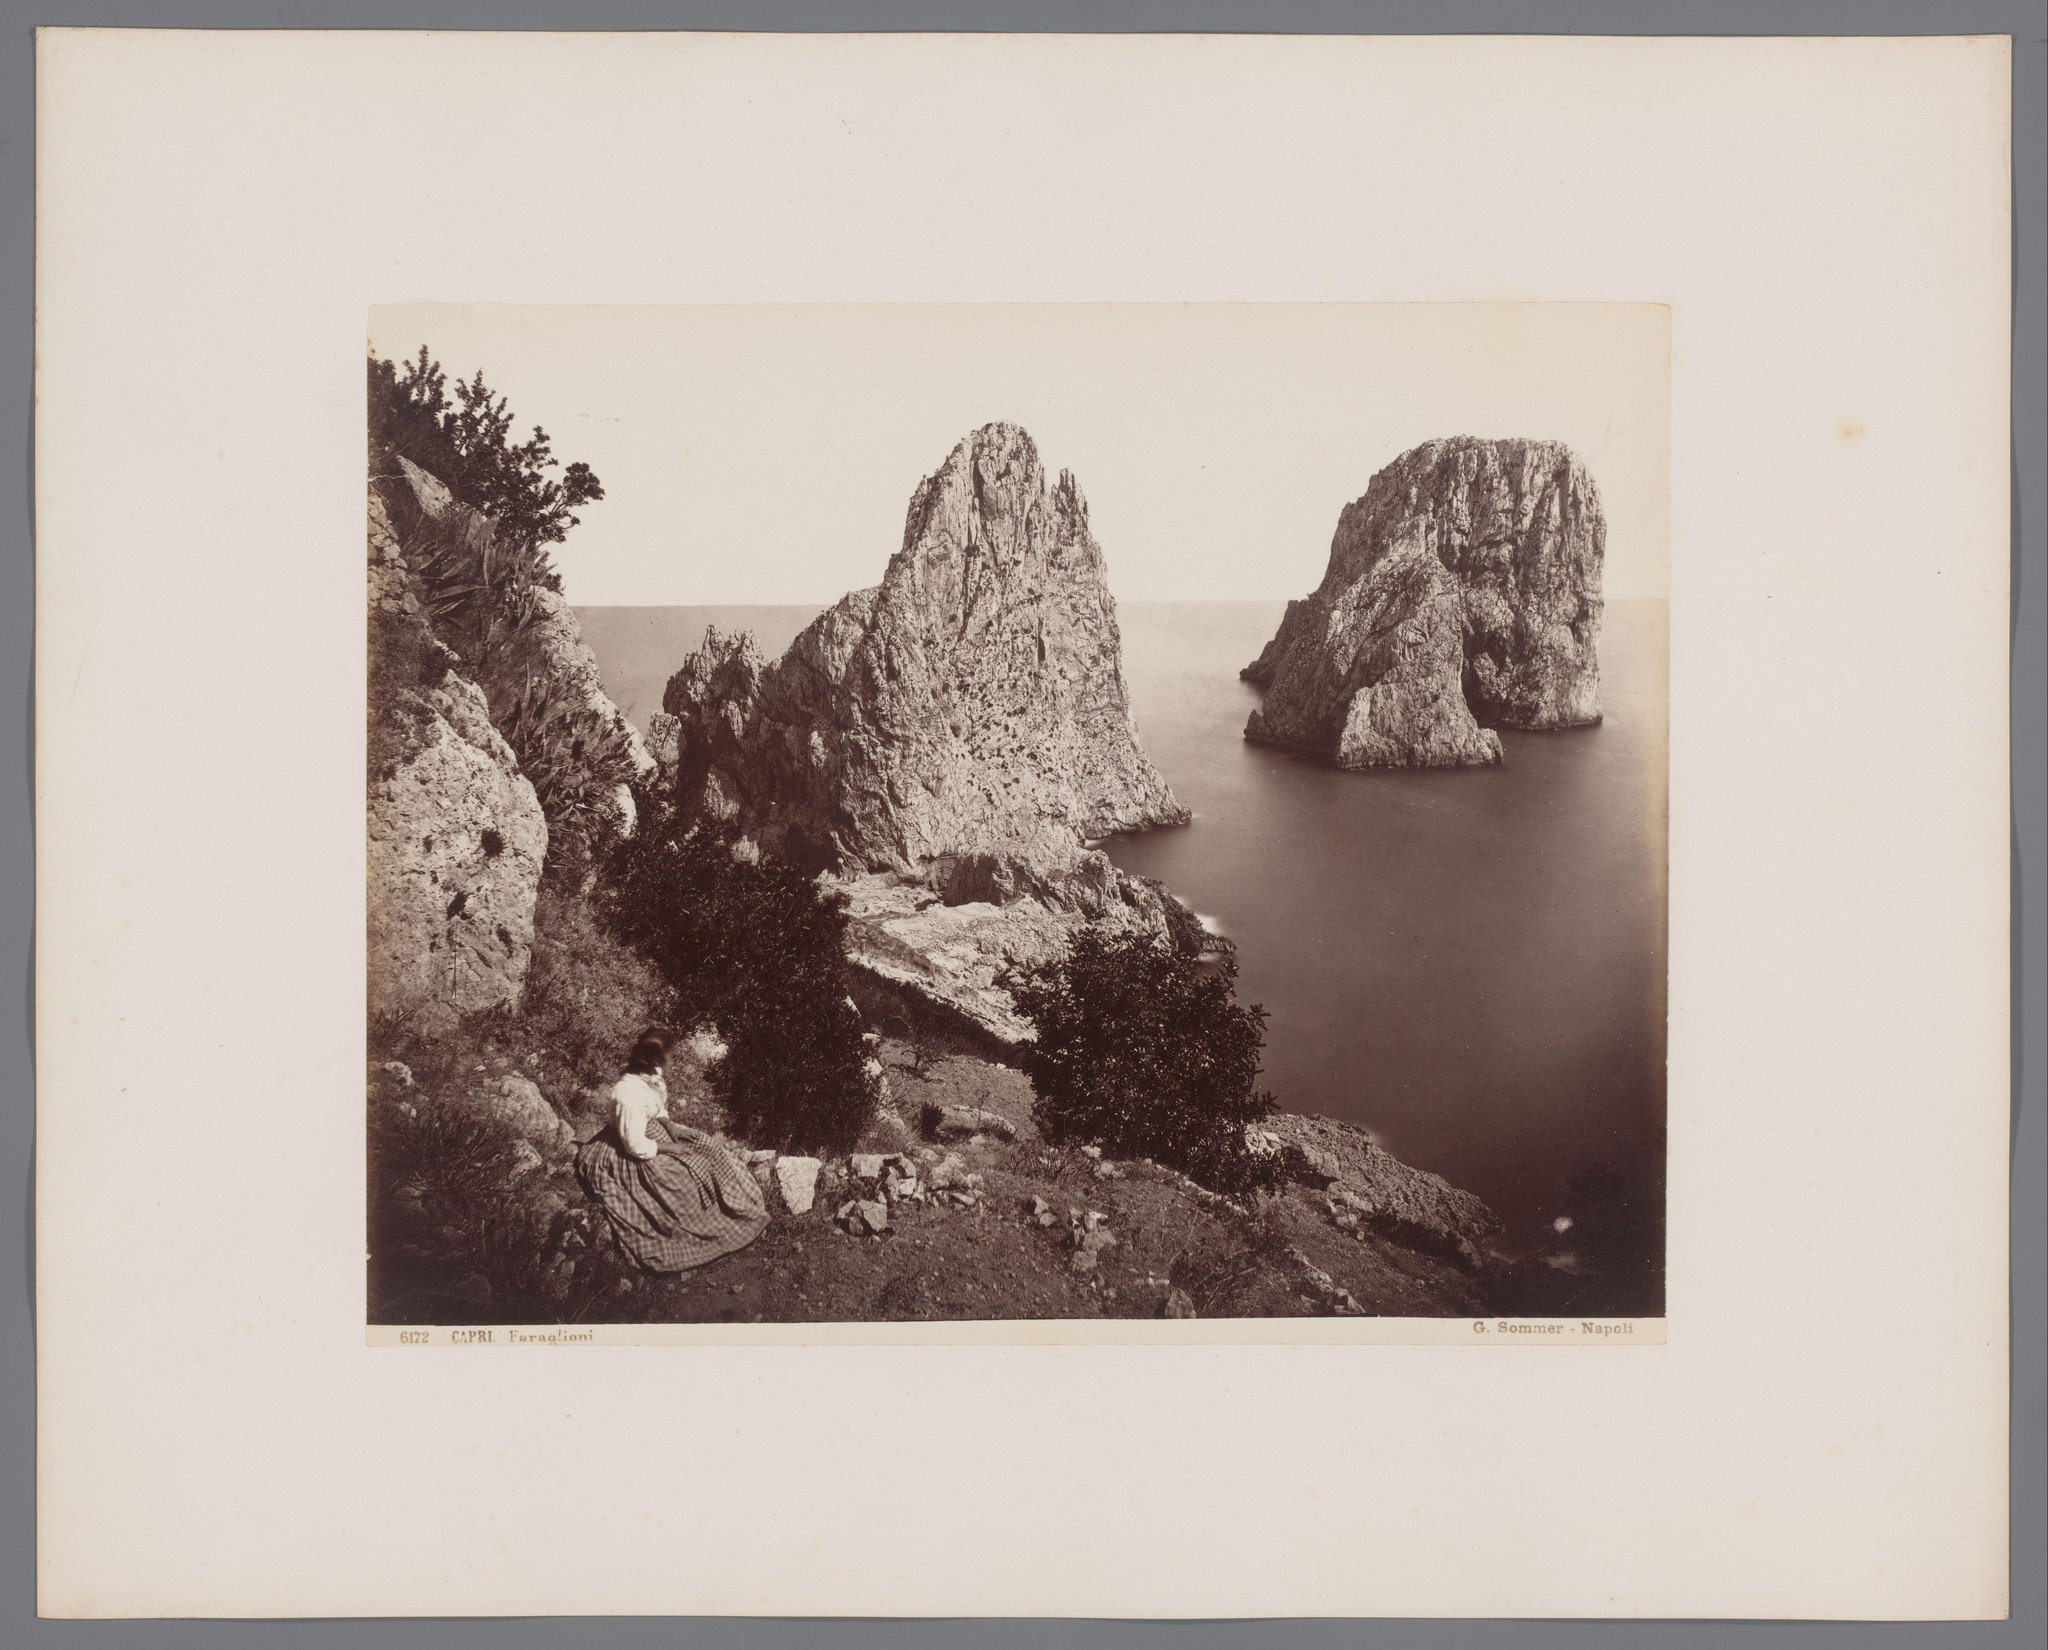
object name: photograph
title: Capri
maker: giorgio sommer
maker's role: fotograaf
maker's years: 1834-1914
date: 1873-1914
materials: cardboard, paper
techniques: albumen print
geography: capri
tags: gulf, bay, rock-formations, capri, isola di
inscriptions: number: ‘6172’